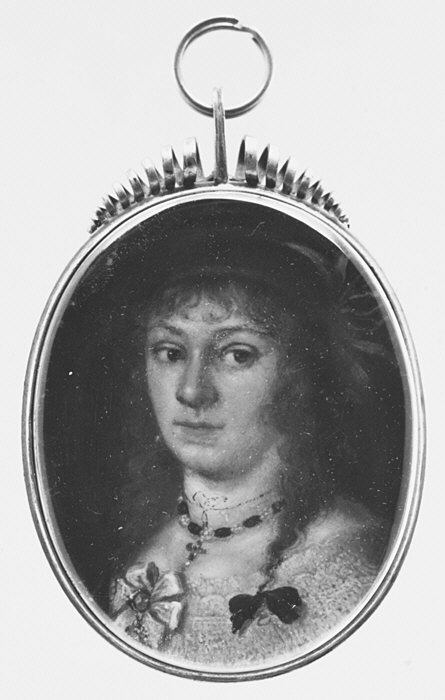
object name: painting, miniature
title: Portrait of a Woman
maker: continental painter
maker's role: artist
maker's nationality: continental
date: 1625-1635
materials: copper, oil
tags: portraits,women